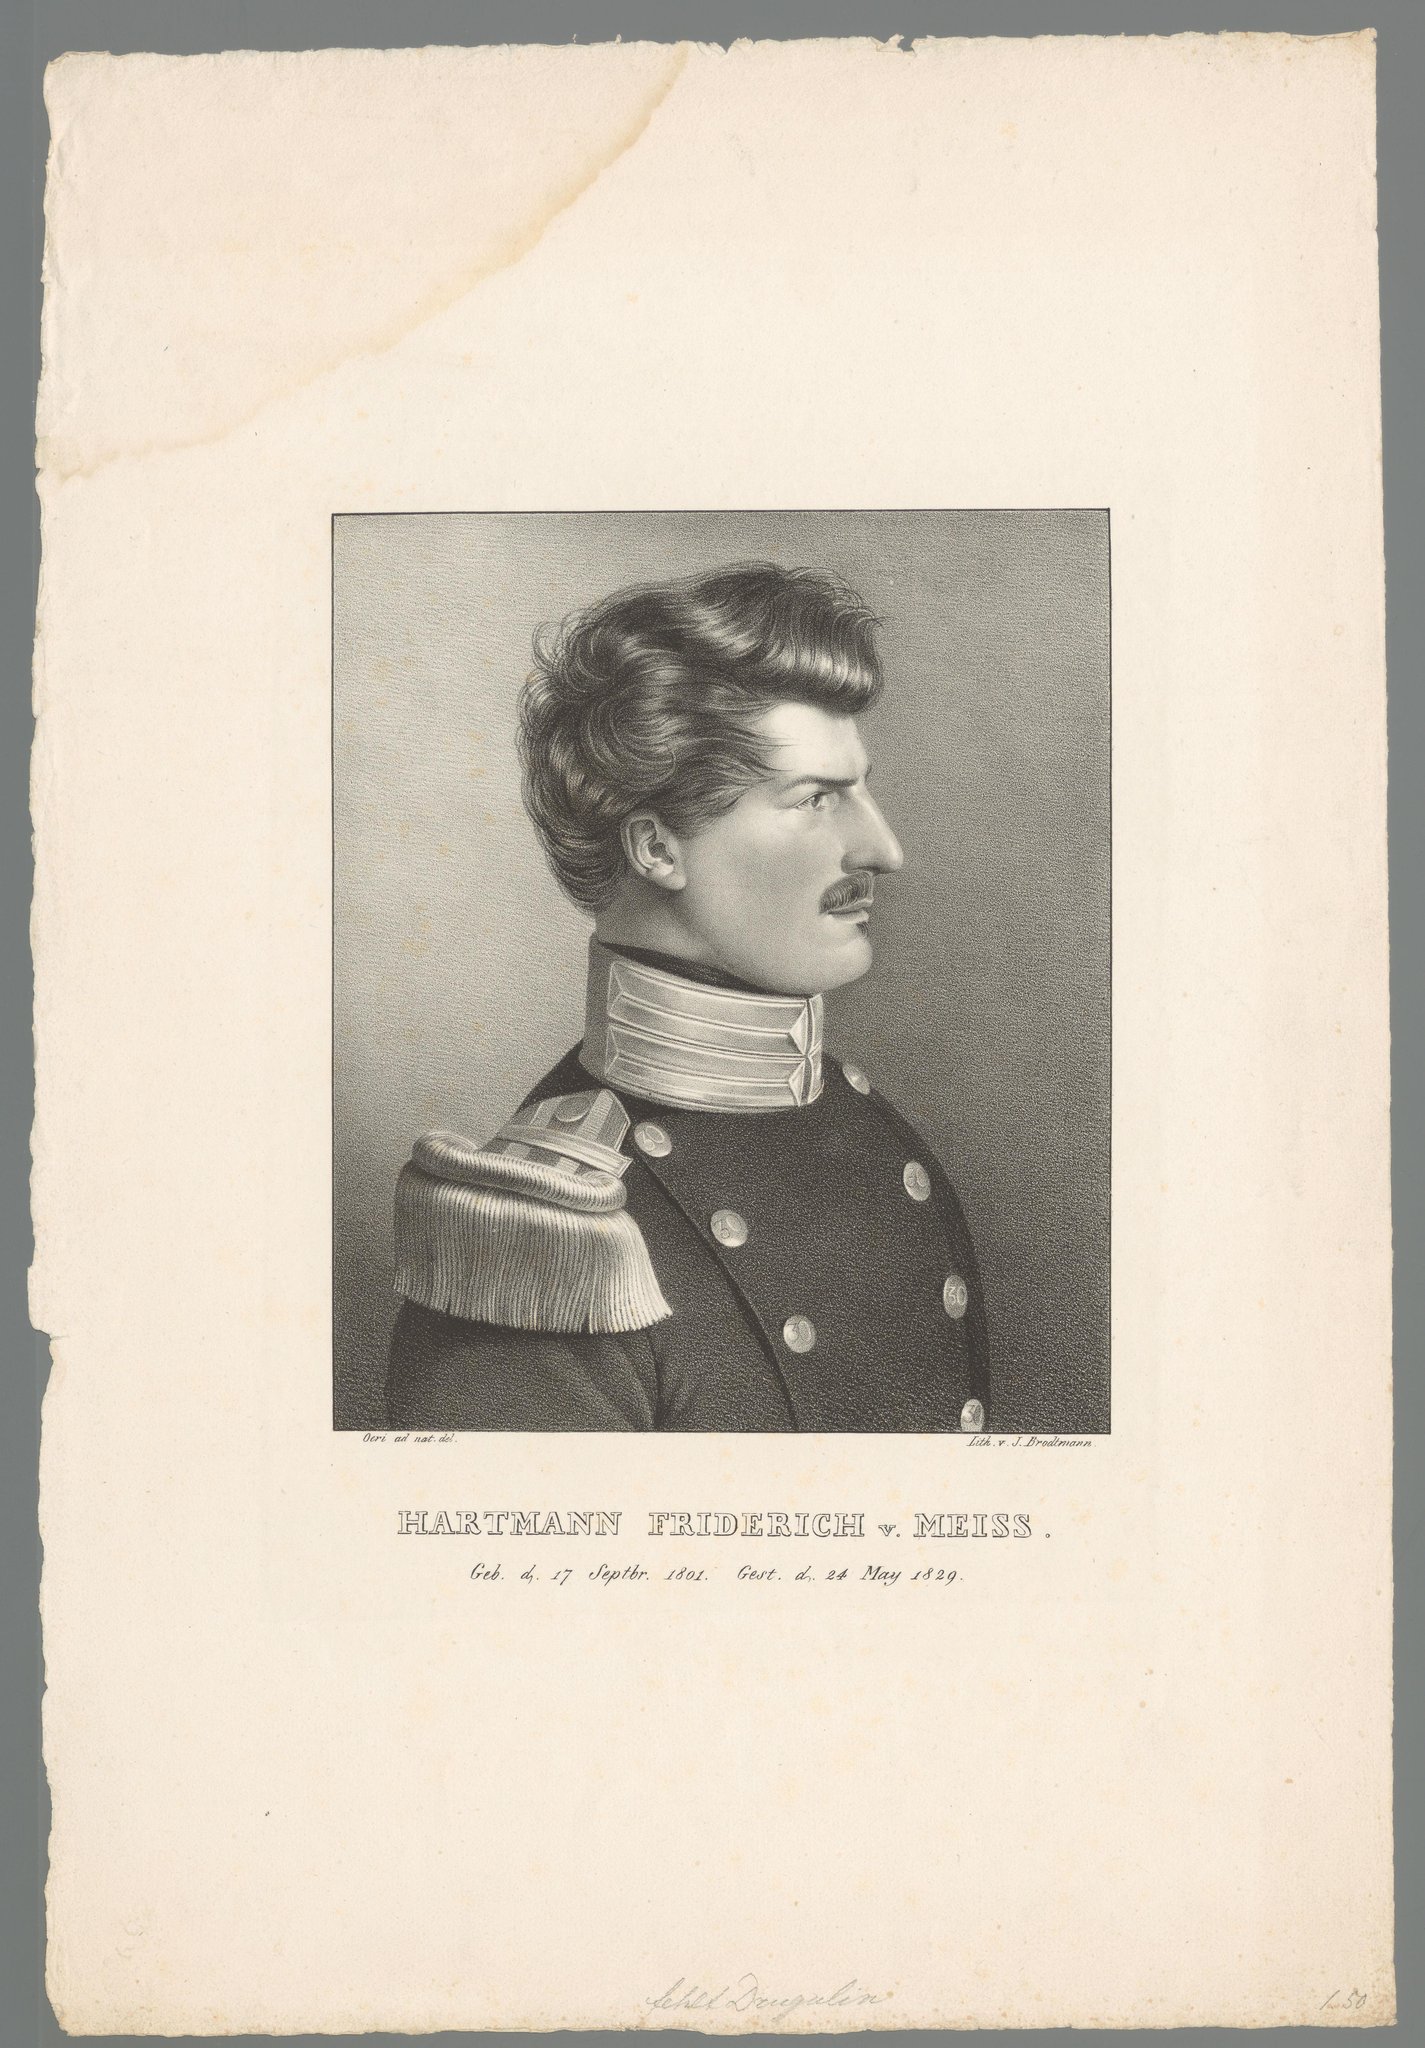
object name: print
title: Portret van Hartmann Friderich von Meiss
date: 1829-1862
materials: paper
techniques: lithograph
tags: moustache, adult man, historical persons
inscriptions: collector's mark: Lugt 2228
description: Op de knopen van zijn uniform staat het getal 30.